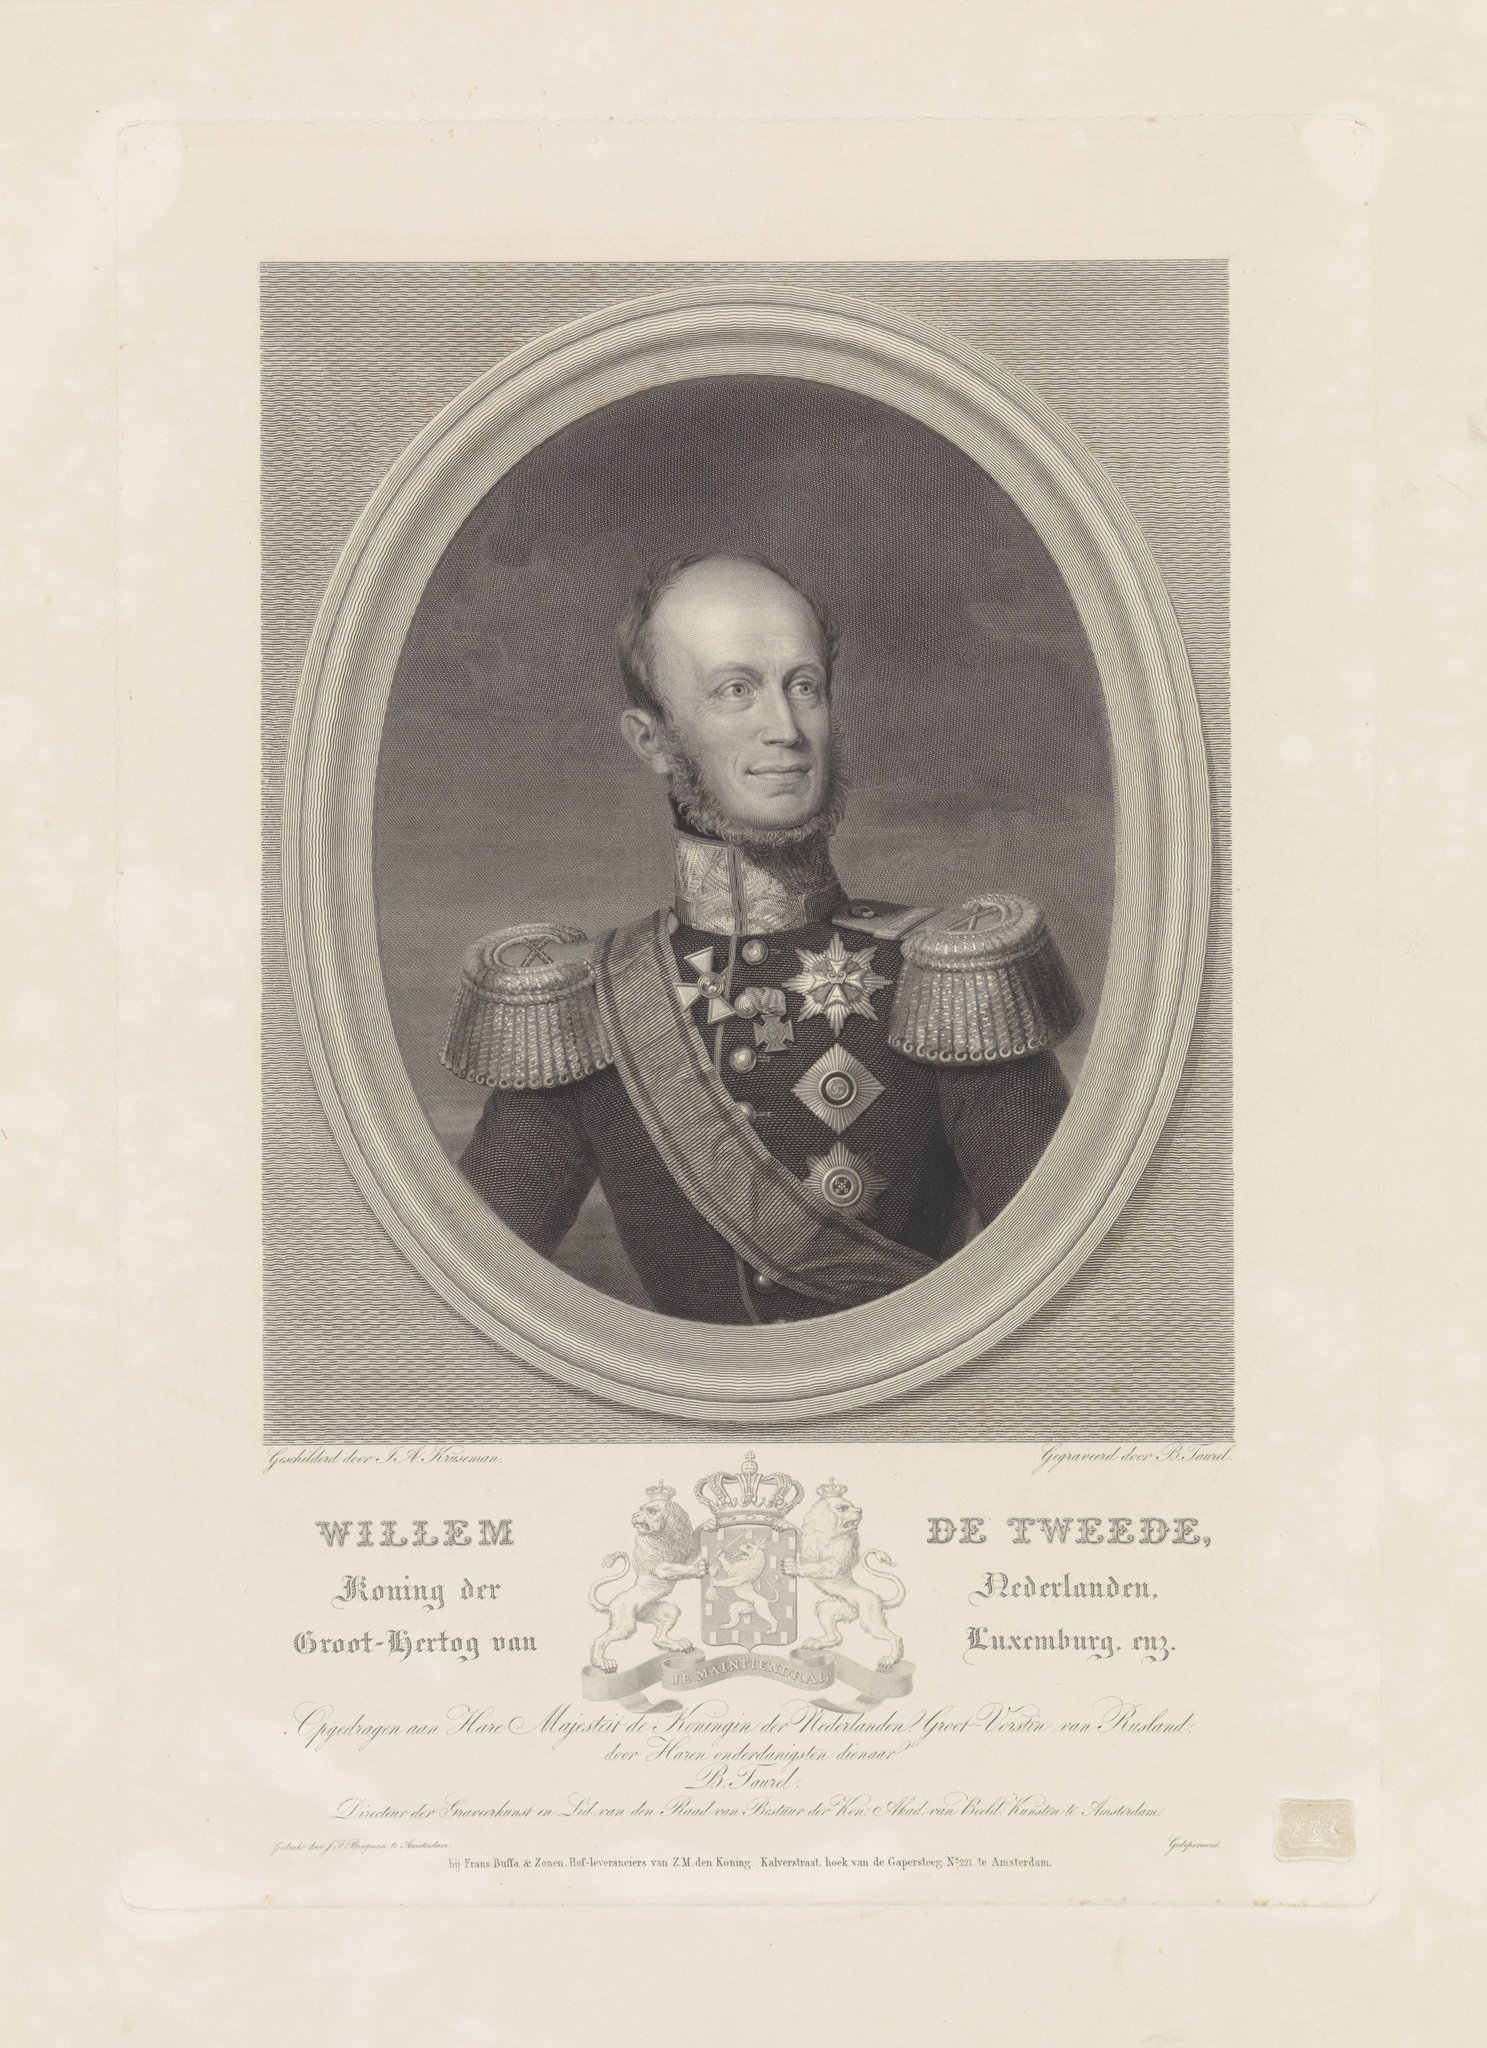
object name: print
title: Portret van Willem II, koning der Nederlanden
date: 1840-1849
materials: paper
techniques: etching, engraving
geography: amsterdam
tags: william ii of the netherlands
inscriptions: check stamp: ‘François Buffa & Fils’, collector's mark: Lugt 12